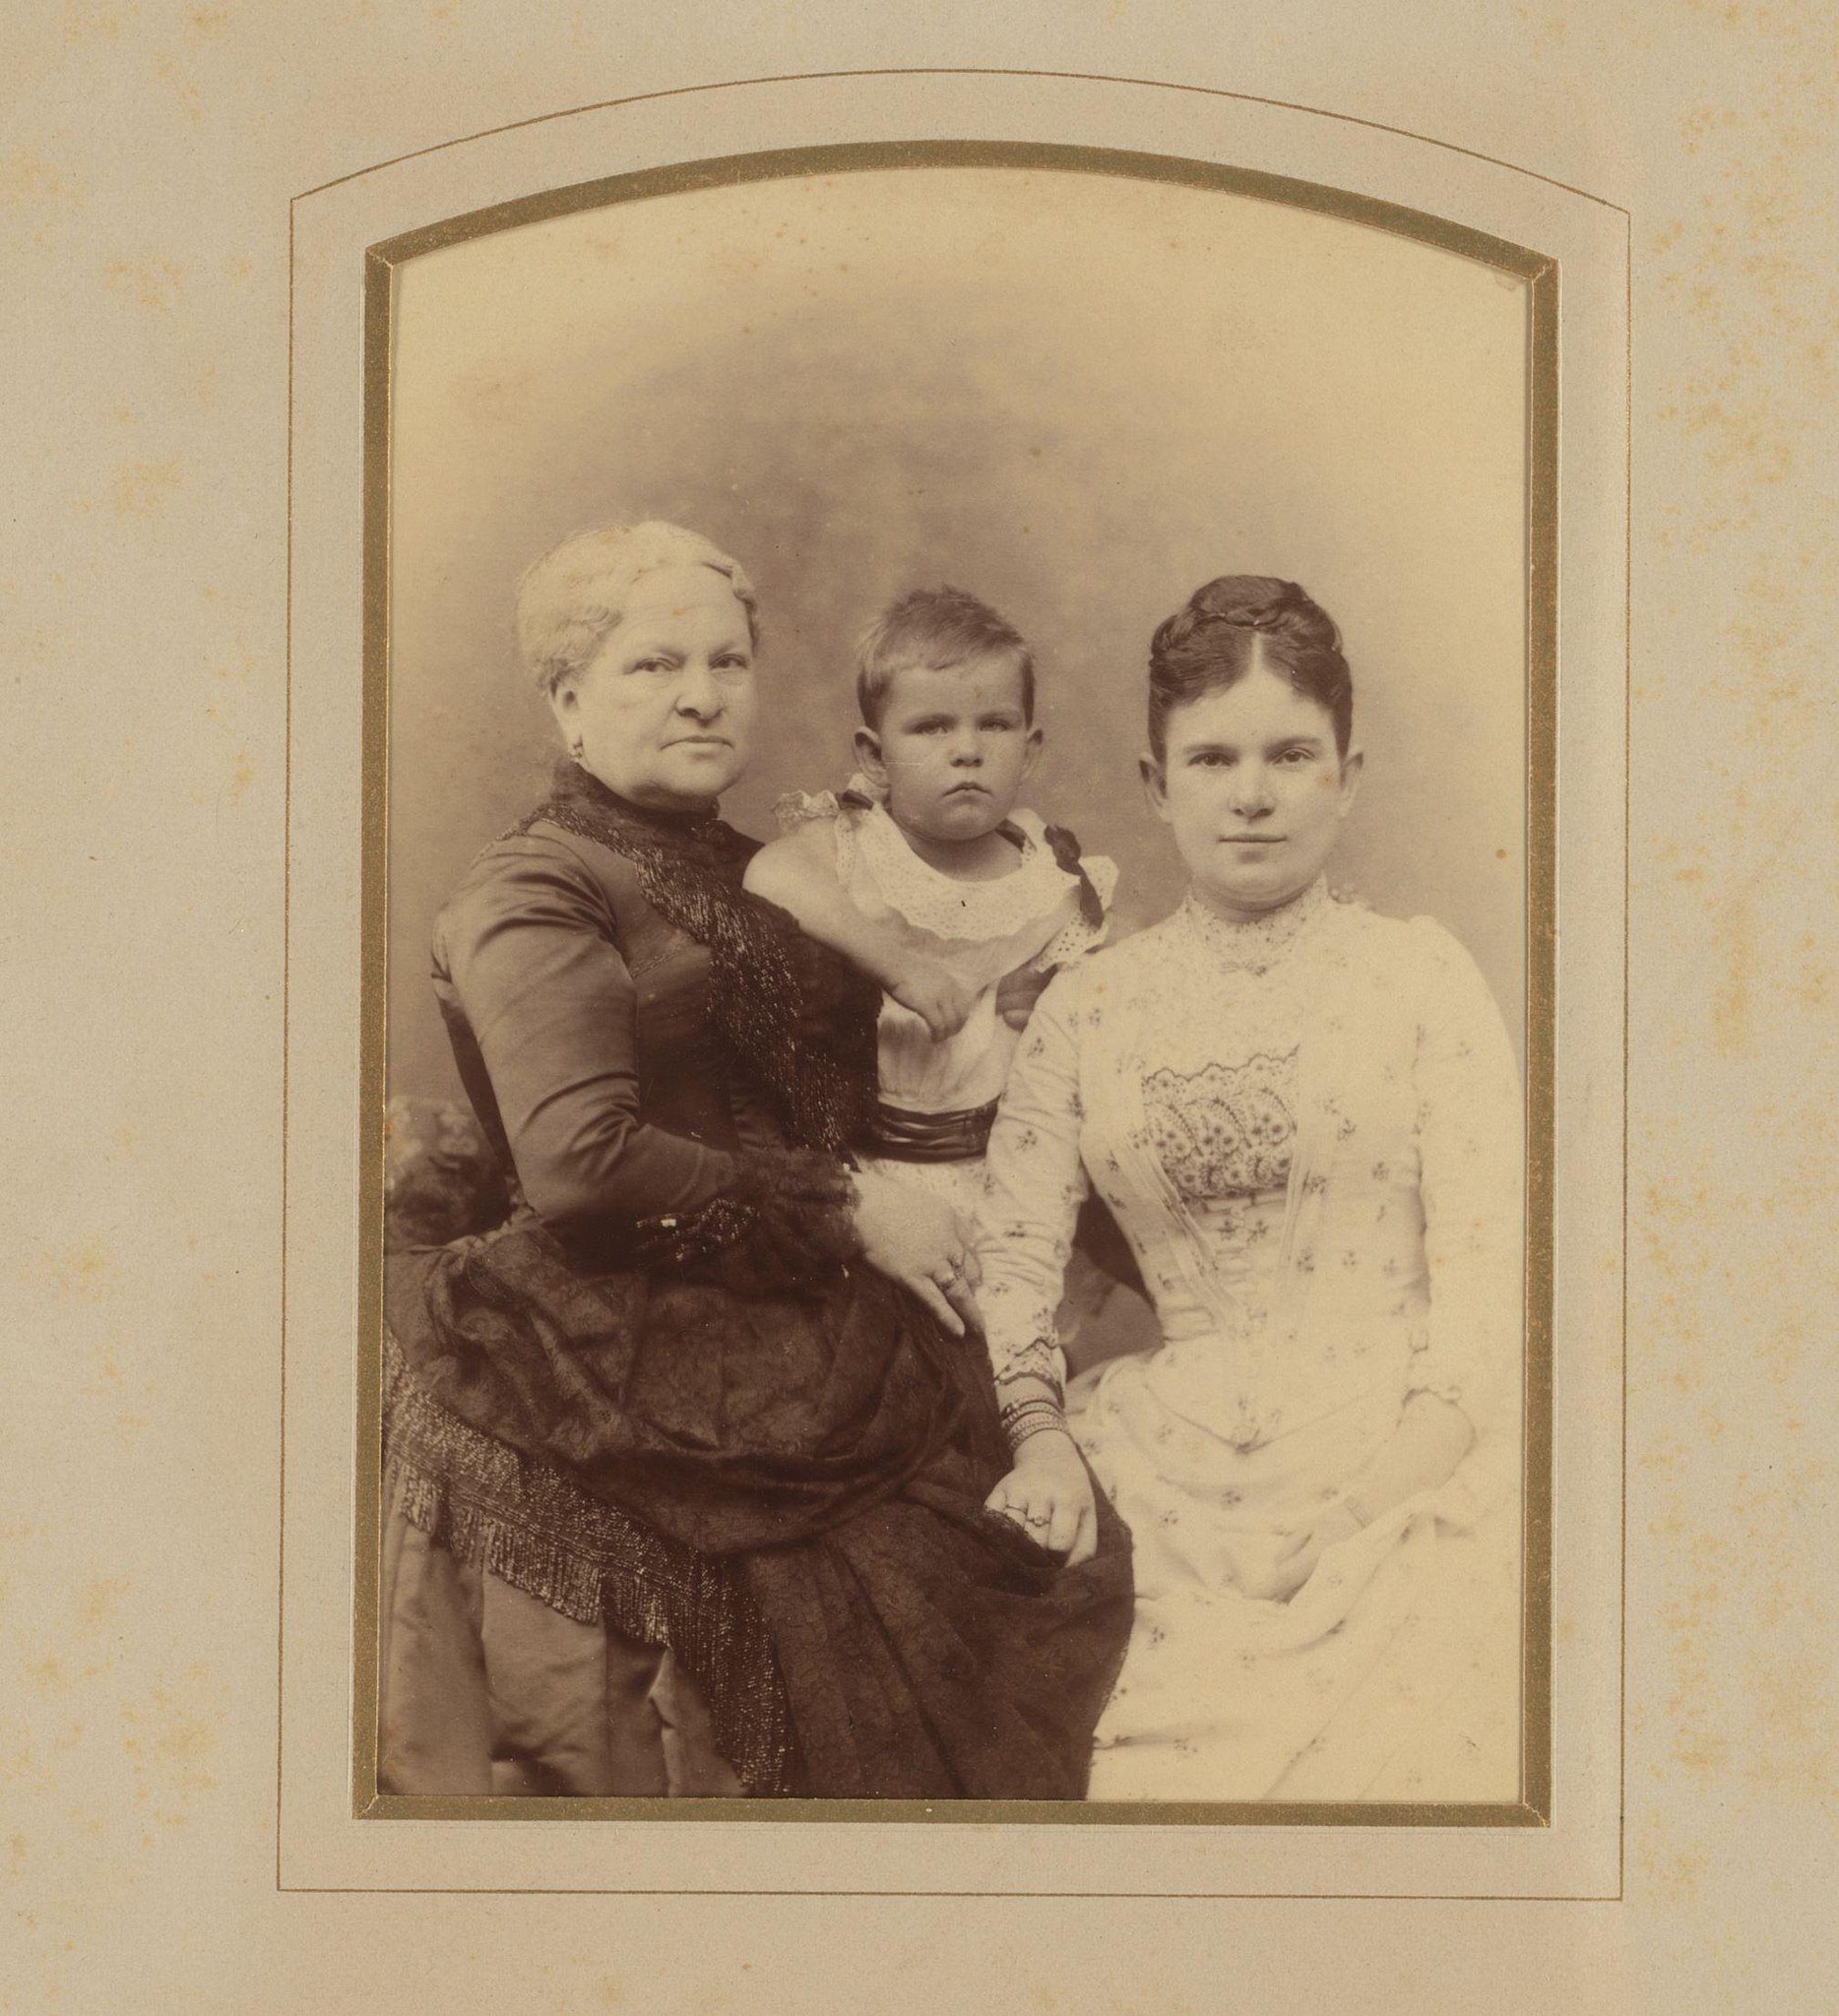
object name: carte de visite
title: Studioportret van mevrouw de Lange-Wiggers van Kerchem, Margo J.J. Kessler-de Lange en baby An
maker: kameke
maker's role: painter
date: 1889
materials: paper, photographic support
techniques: photography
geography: the hague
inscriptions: inscription: ‘Dit lijkt mij t best’